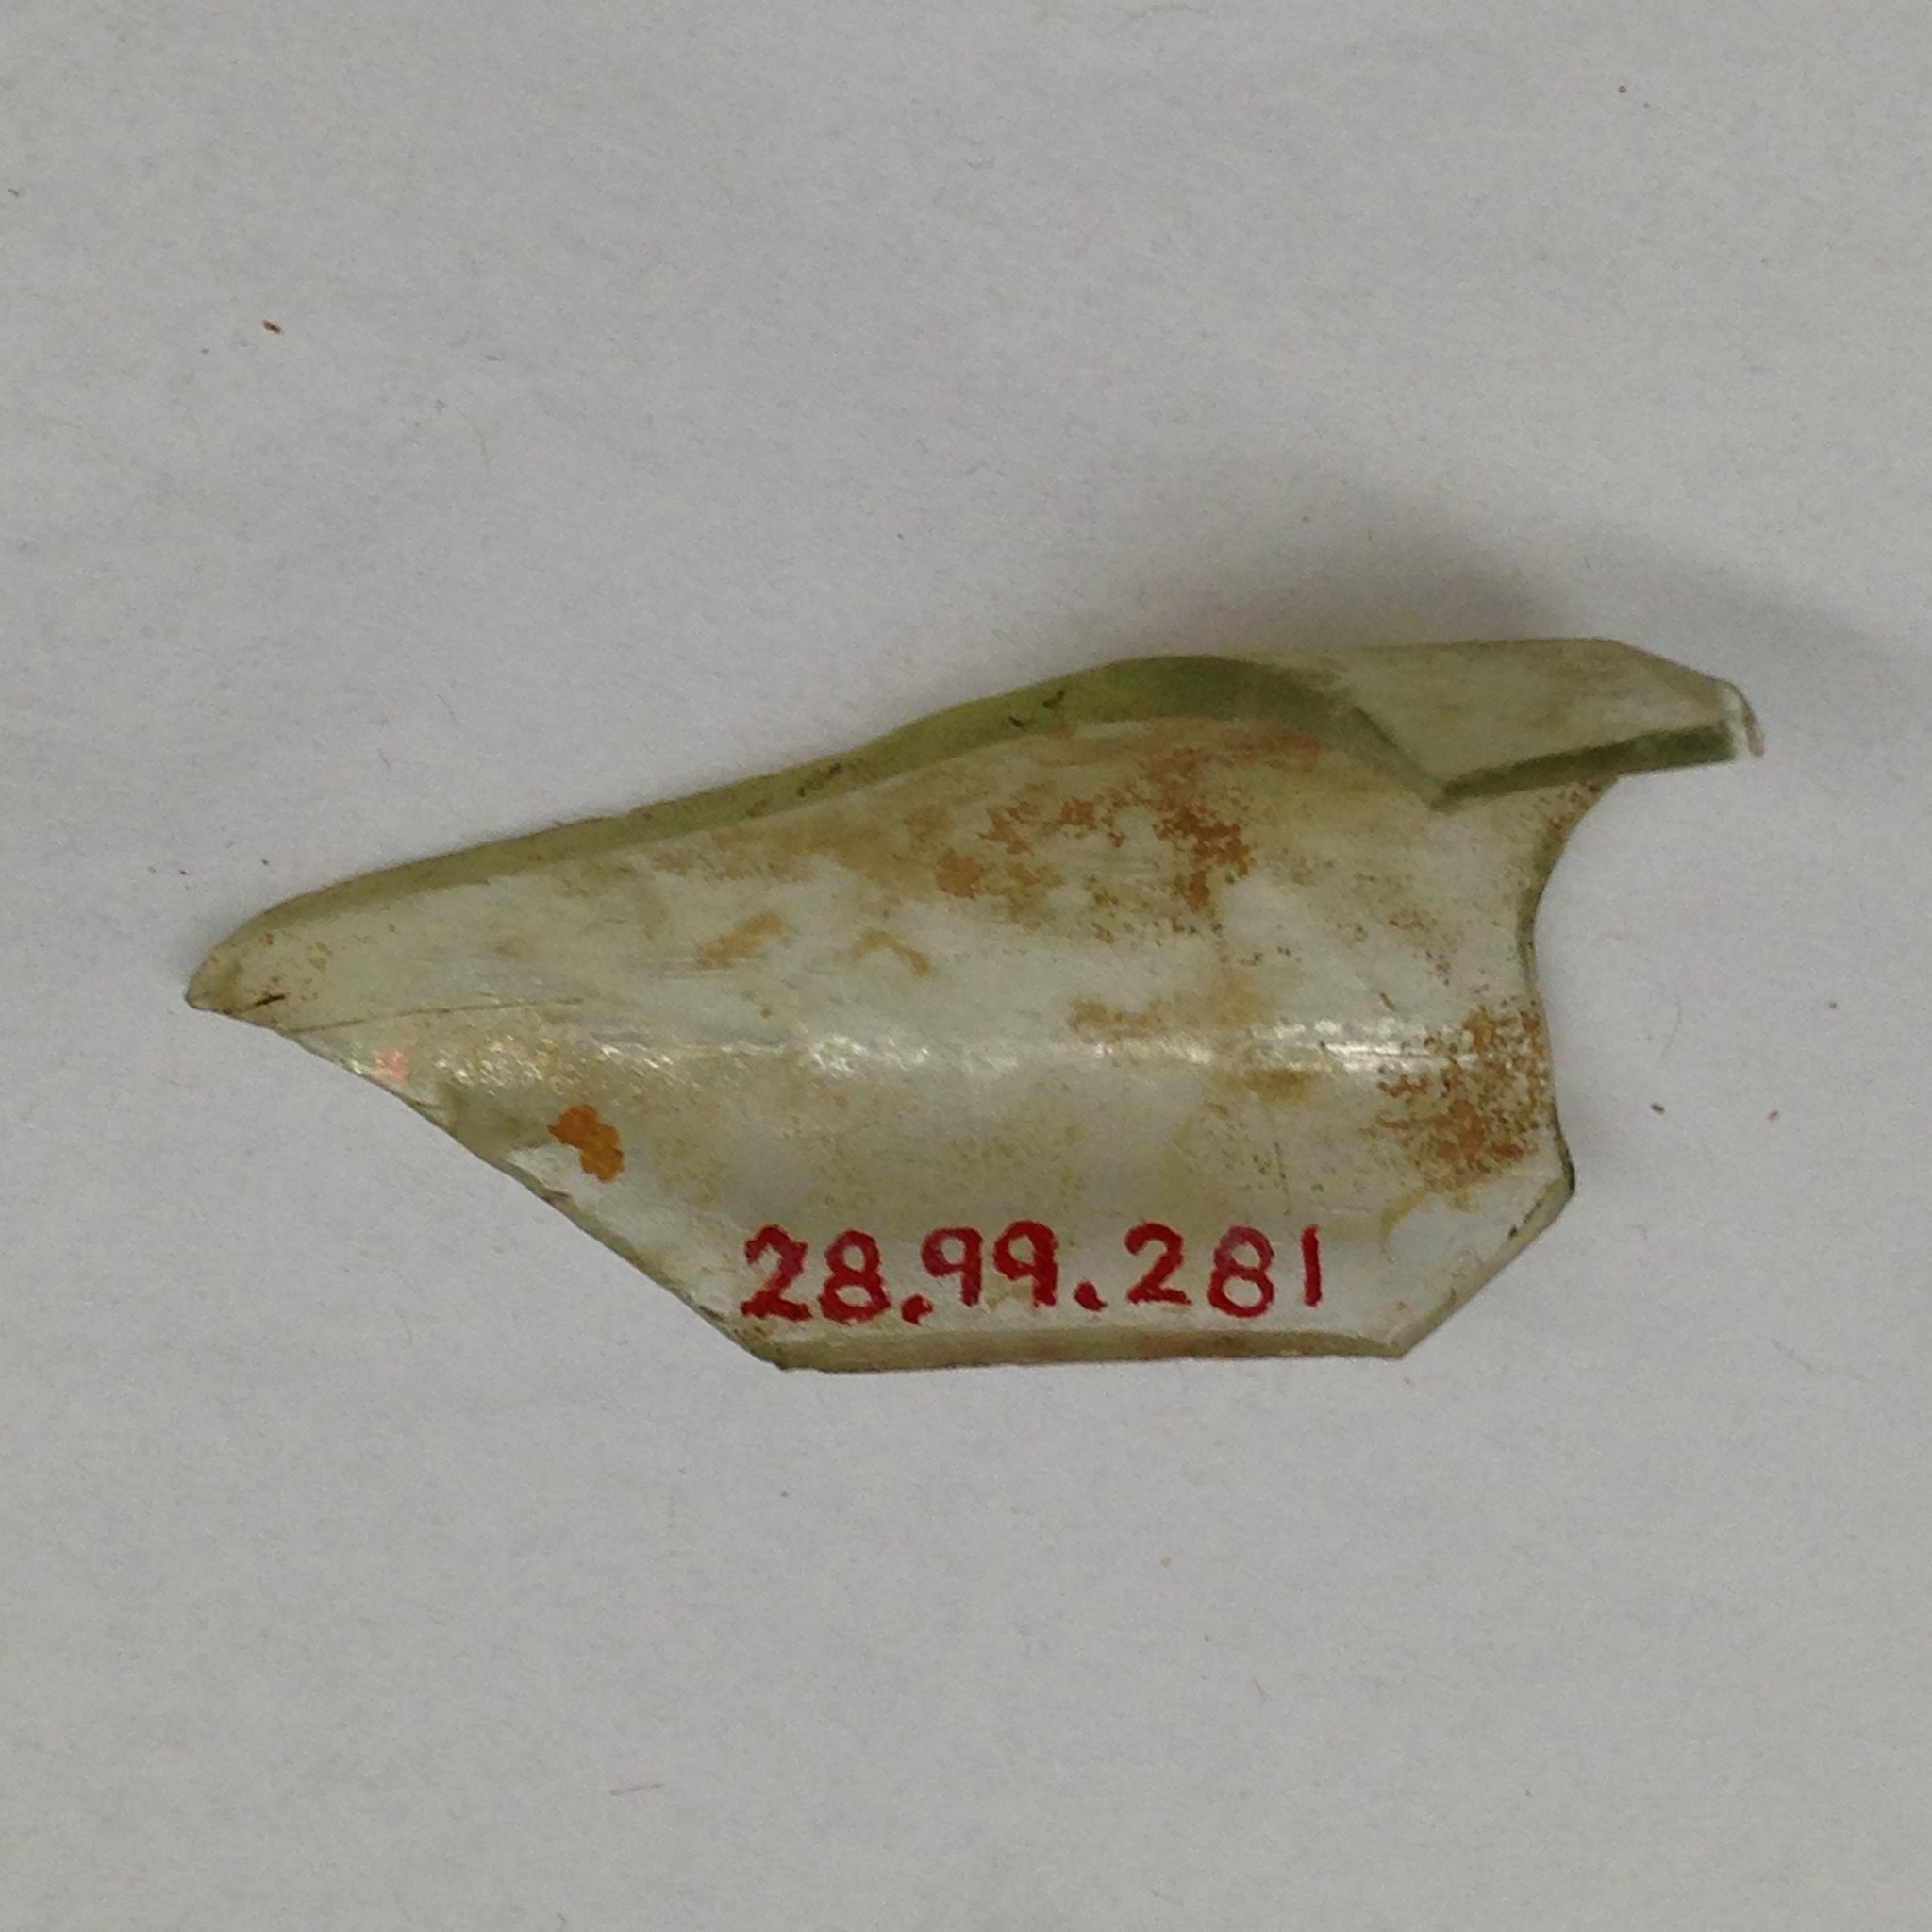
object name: fragment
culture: european or middle eastern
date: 1150-1250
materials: ceramic, glass